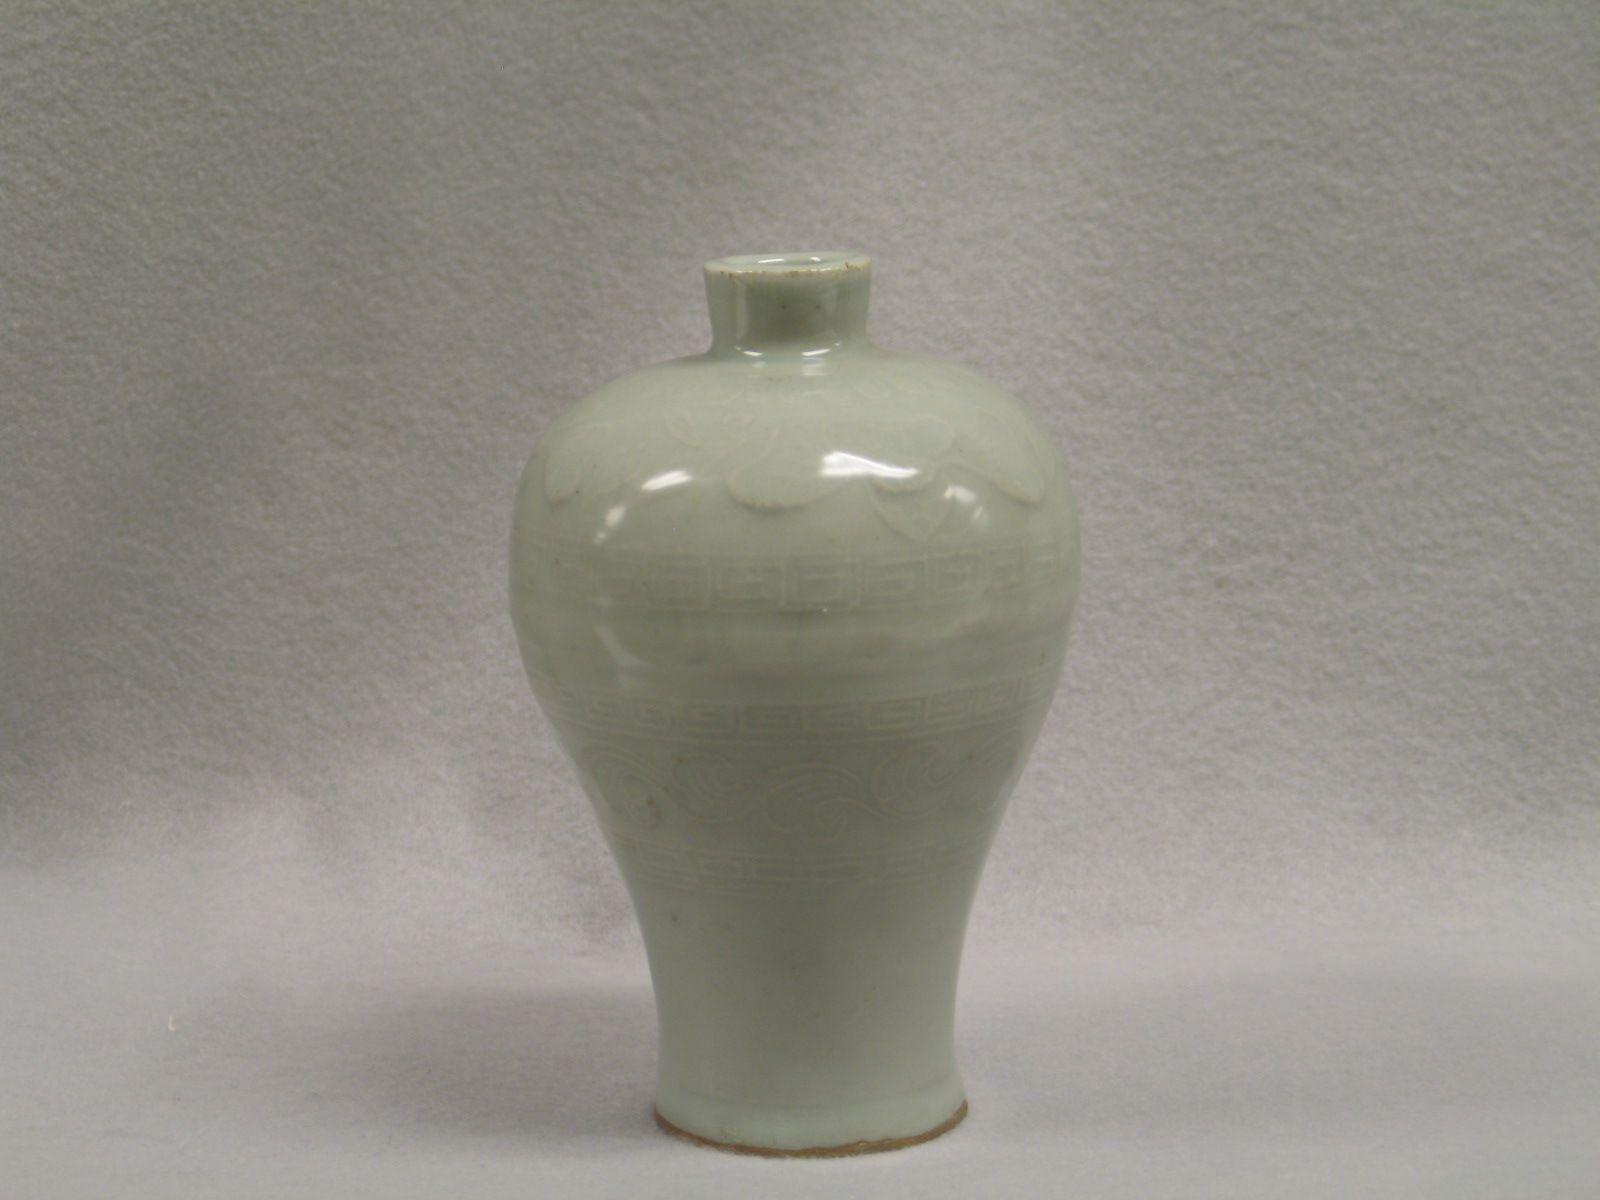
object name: vase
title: Meiping vase with floral patterns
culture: chinese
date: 1201-1400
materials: ceramic glaze, glaze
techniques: incising